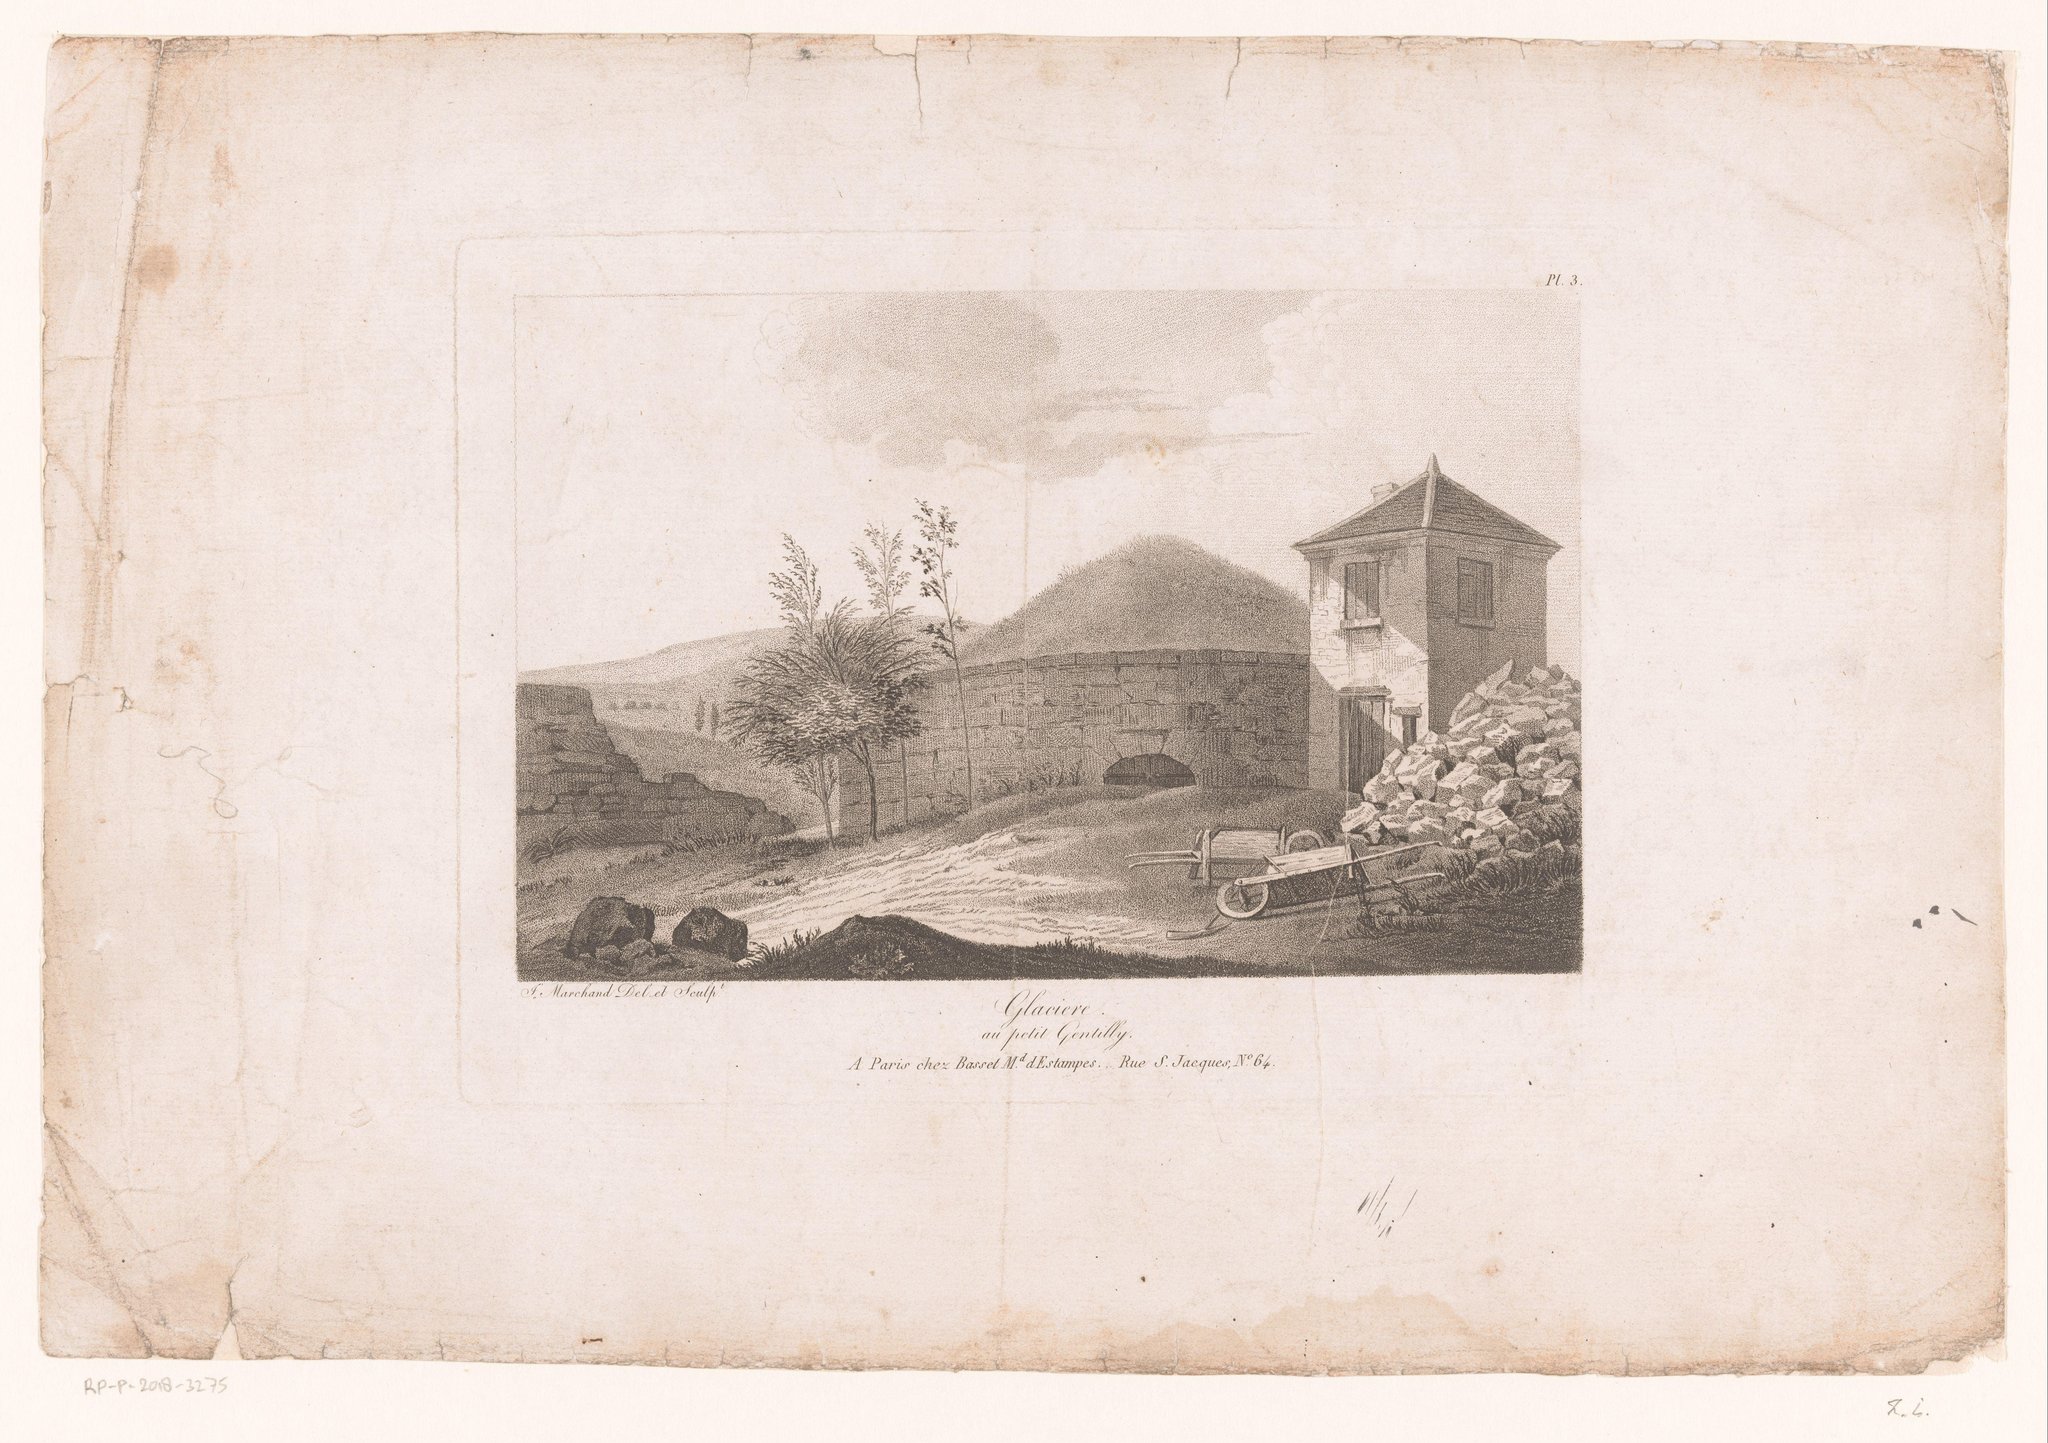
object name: print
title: Glaciere au petit Gentilly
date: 1780-1787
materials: paper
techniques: etching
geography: paris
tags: city-view, and landscape with man-made constructions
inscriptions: collector's mark: Lugt 2228